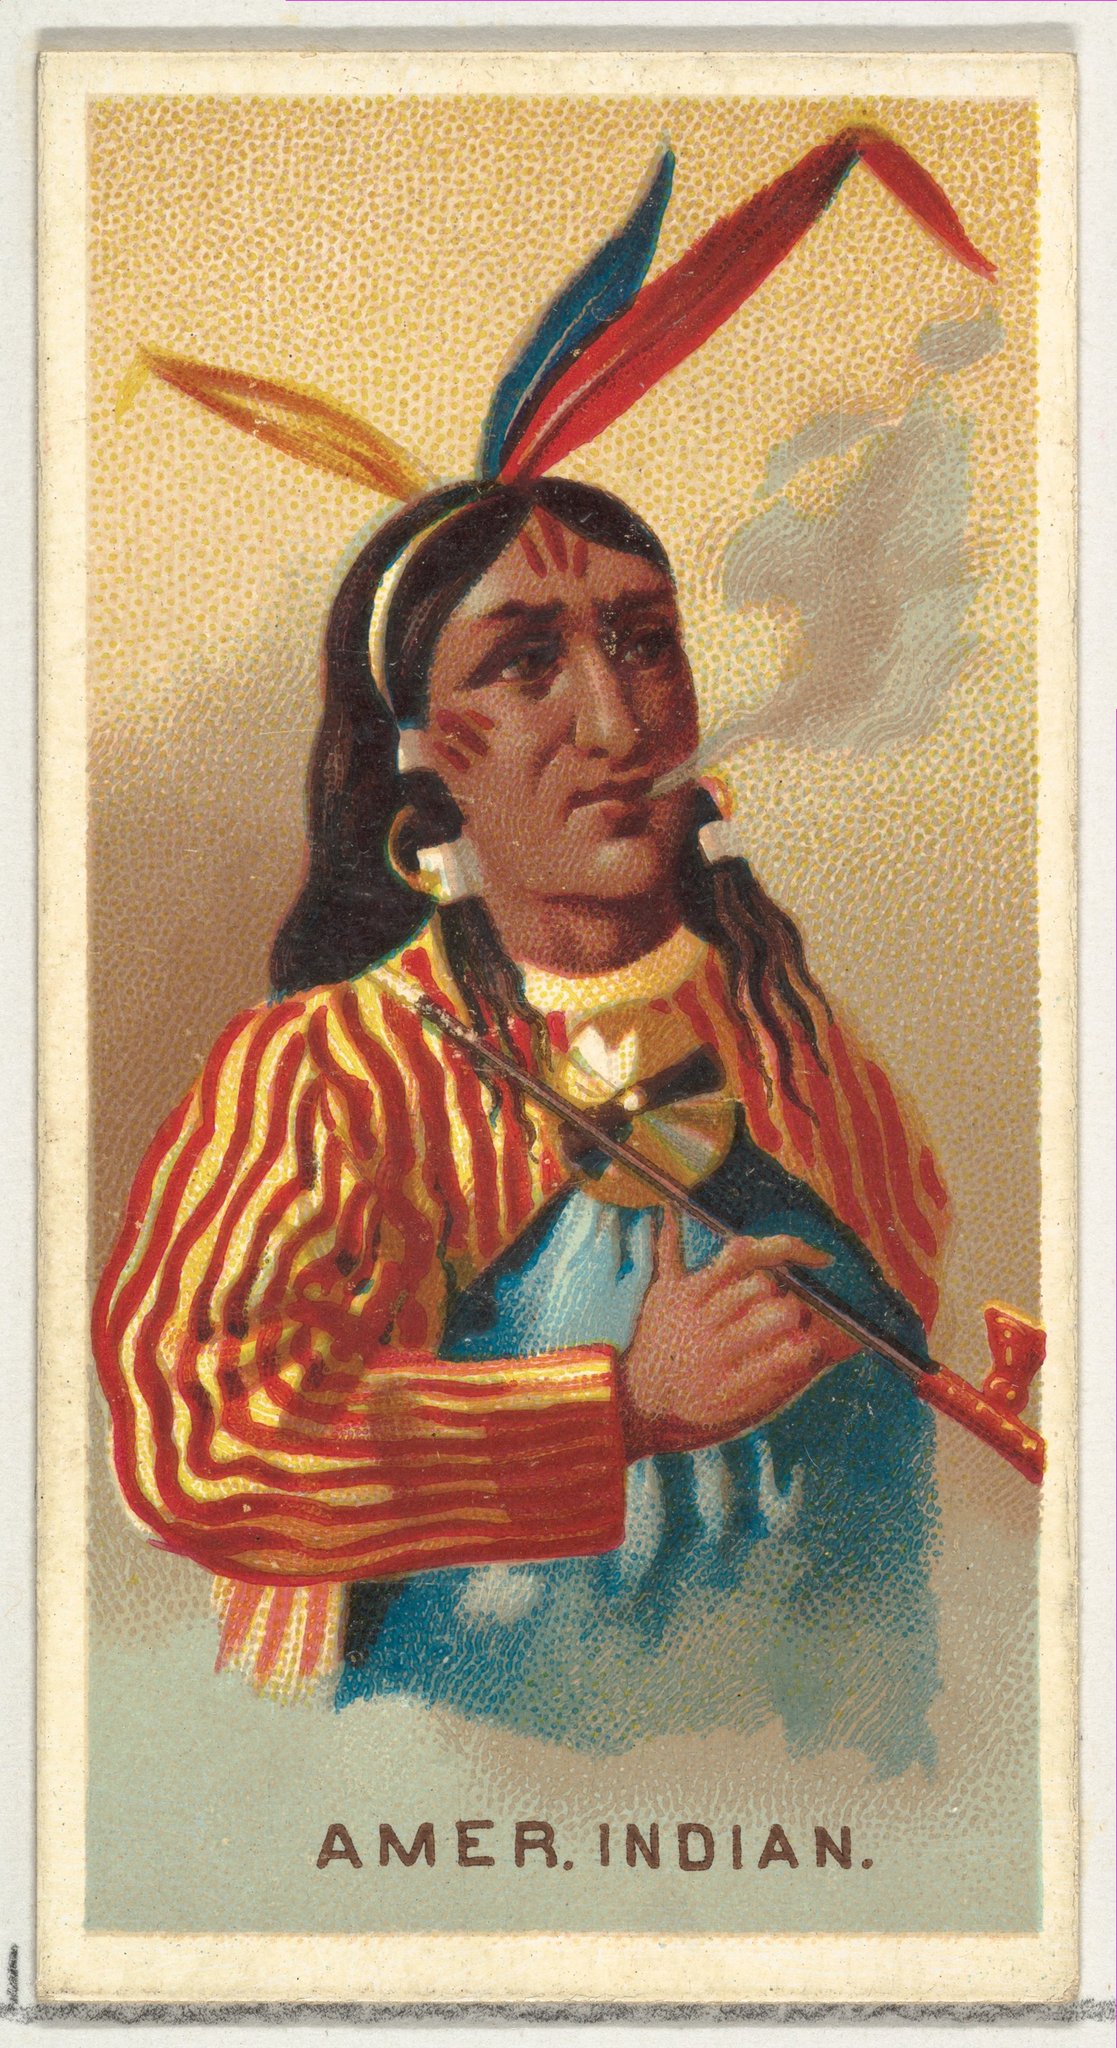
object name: print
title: American Indian, from World's Smokers series (N33) for Allen & Ginter Cigarettes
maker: allen & ginter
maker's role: publisher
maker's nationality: american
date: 1888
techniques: color lithograph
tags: women,smoking